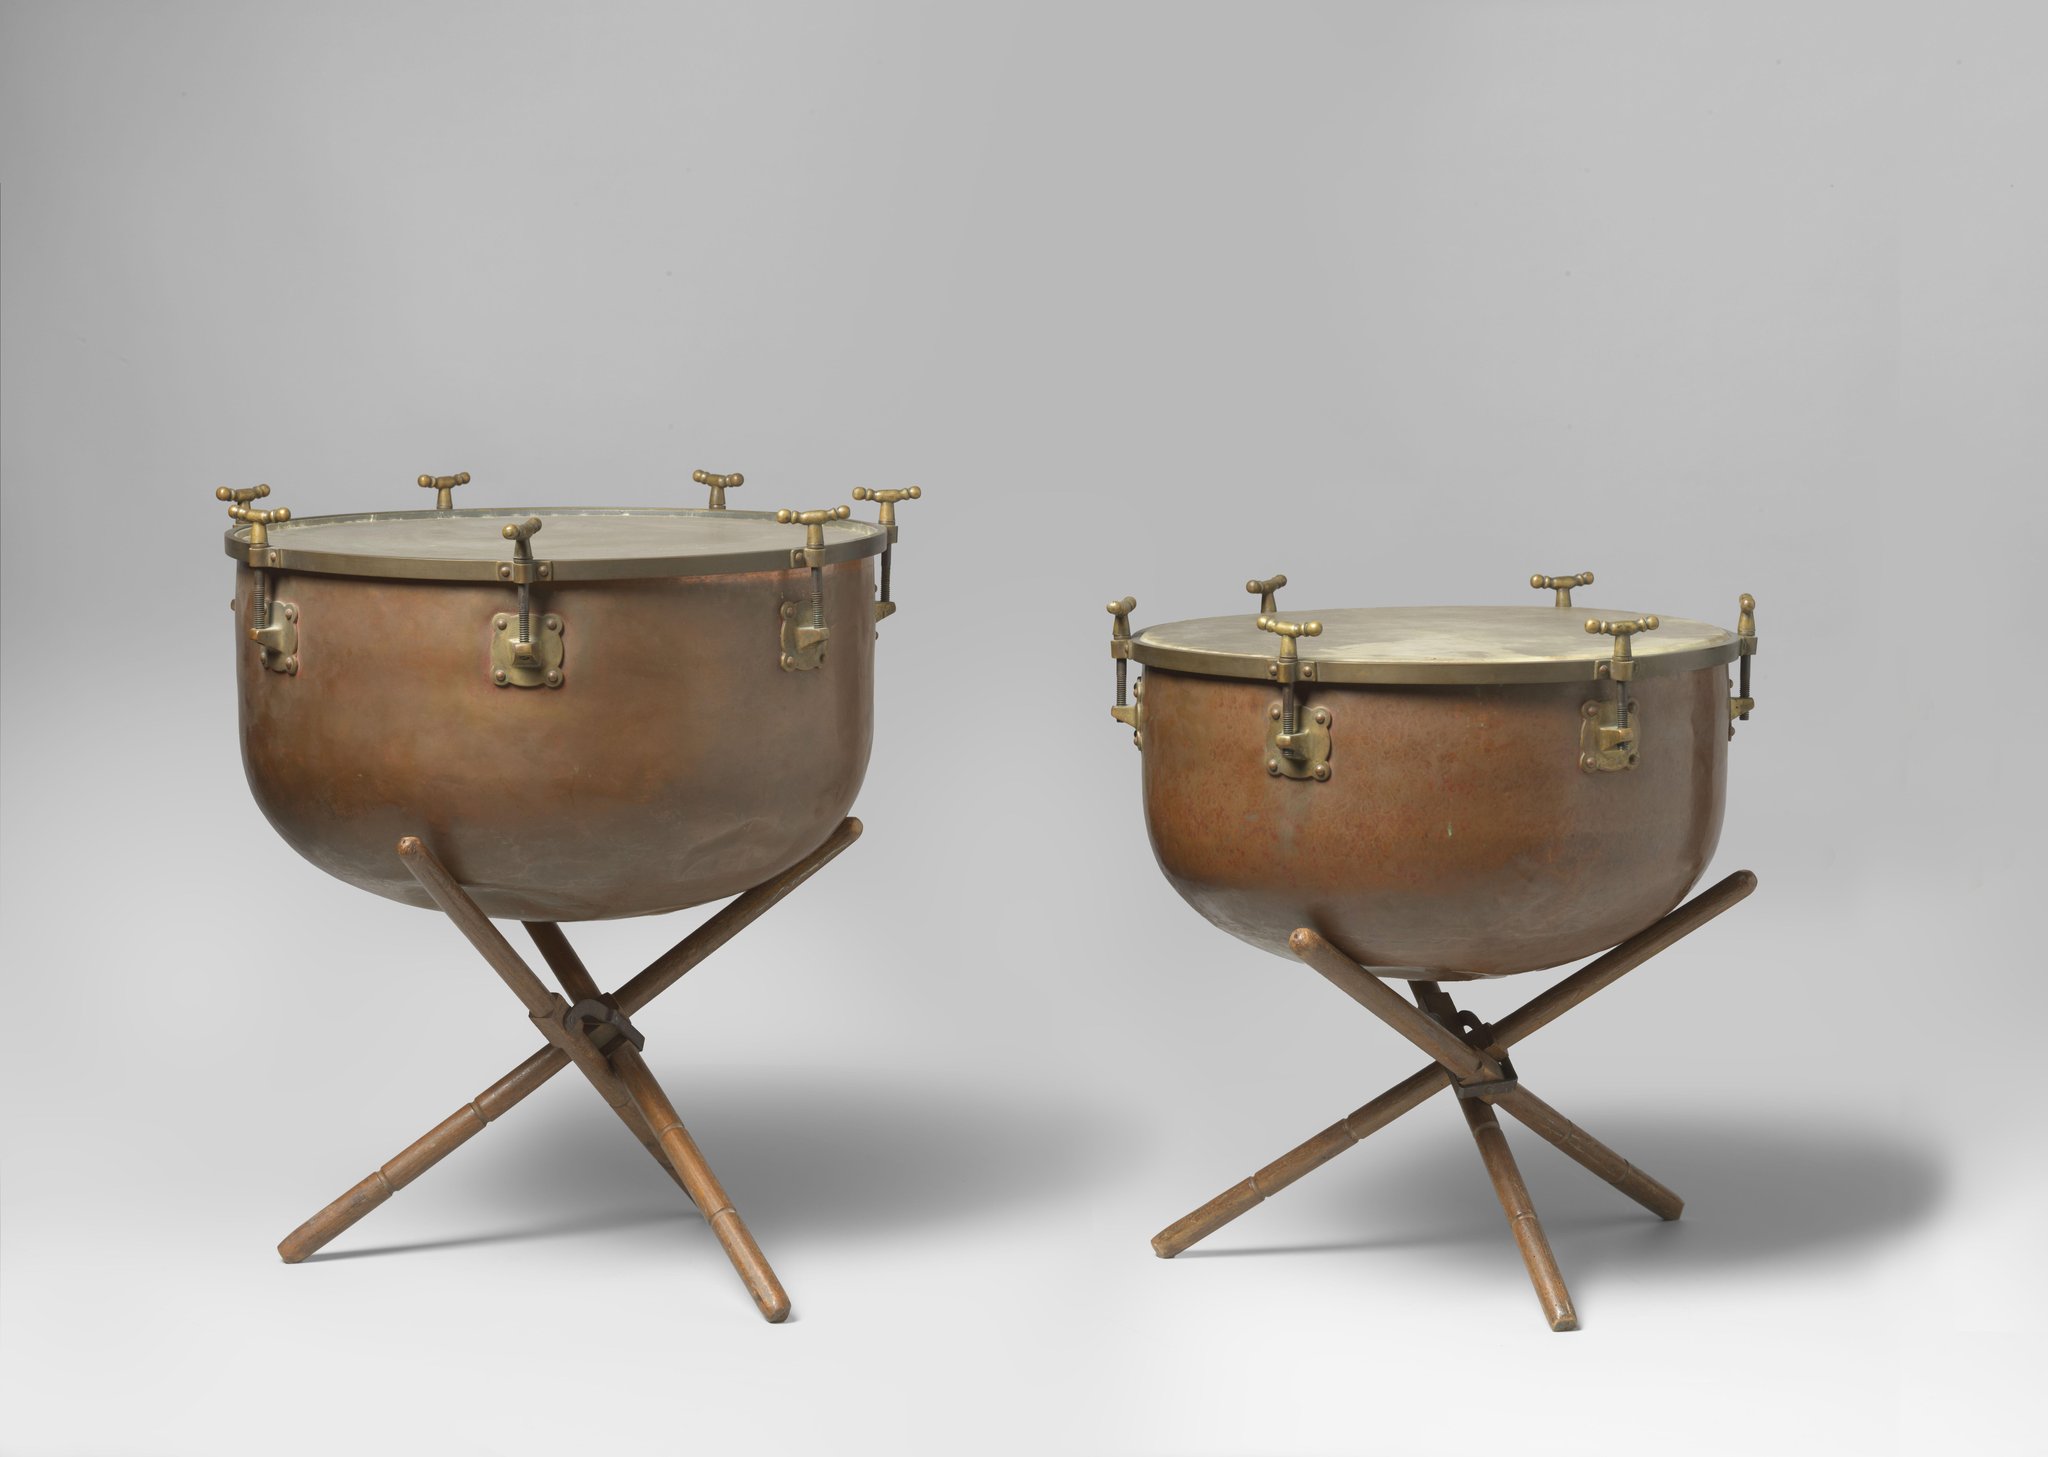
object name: timpani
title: Kettle drums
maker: Anonymous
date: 1850-1899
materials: brass, leather, wood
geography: europe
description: Set van twee vroeg 19e-eeuwse pauken, gemaakt van koper met messing stemschroeven, op originele onderstellen.